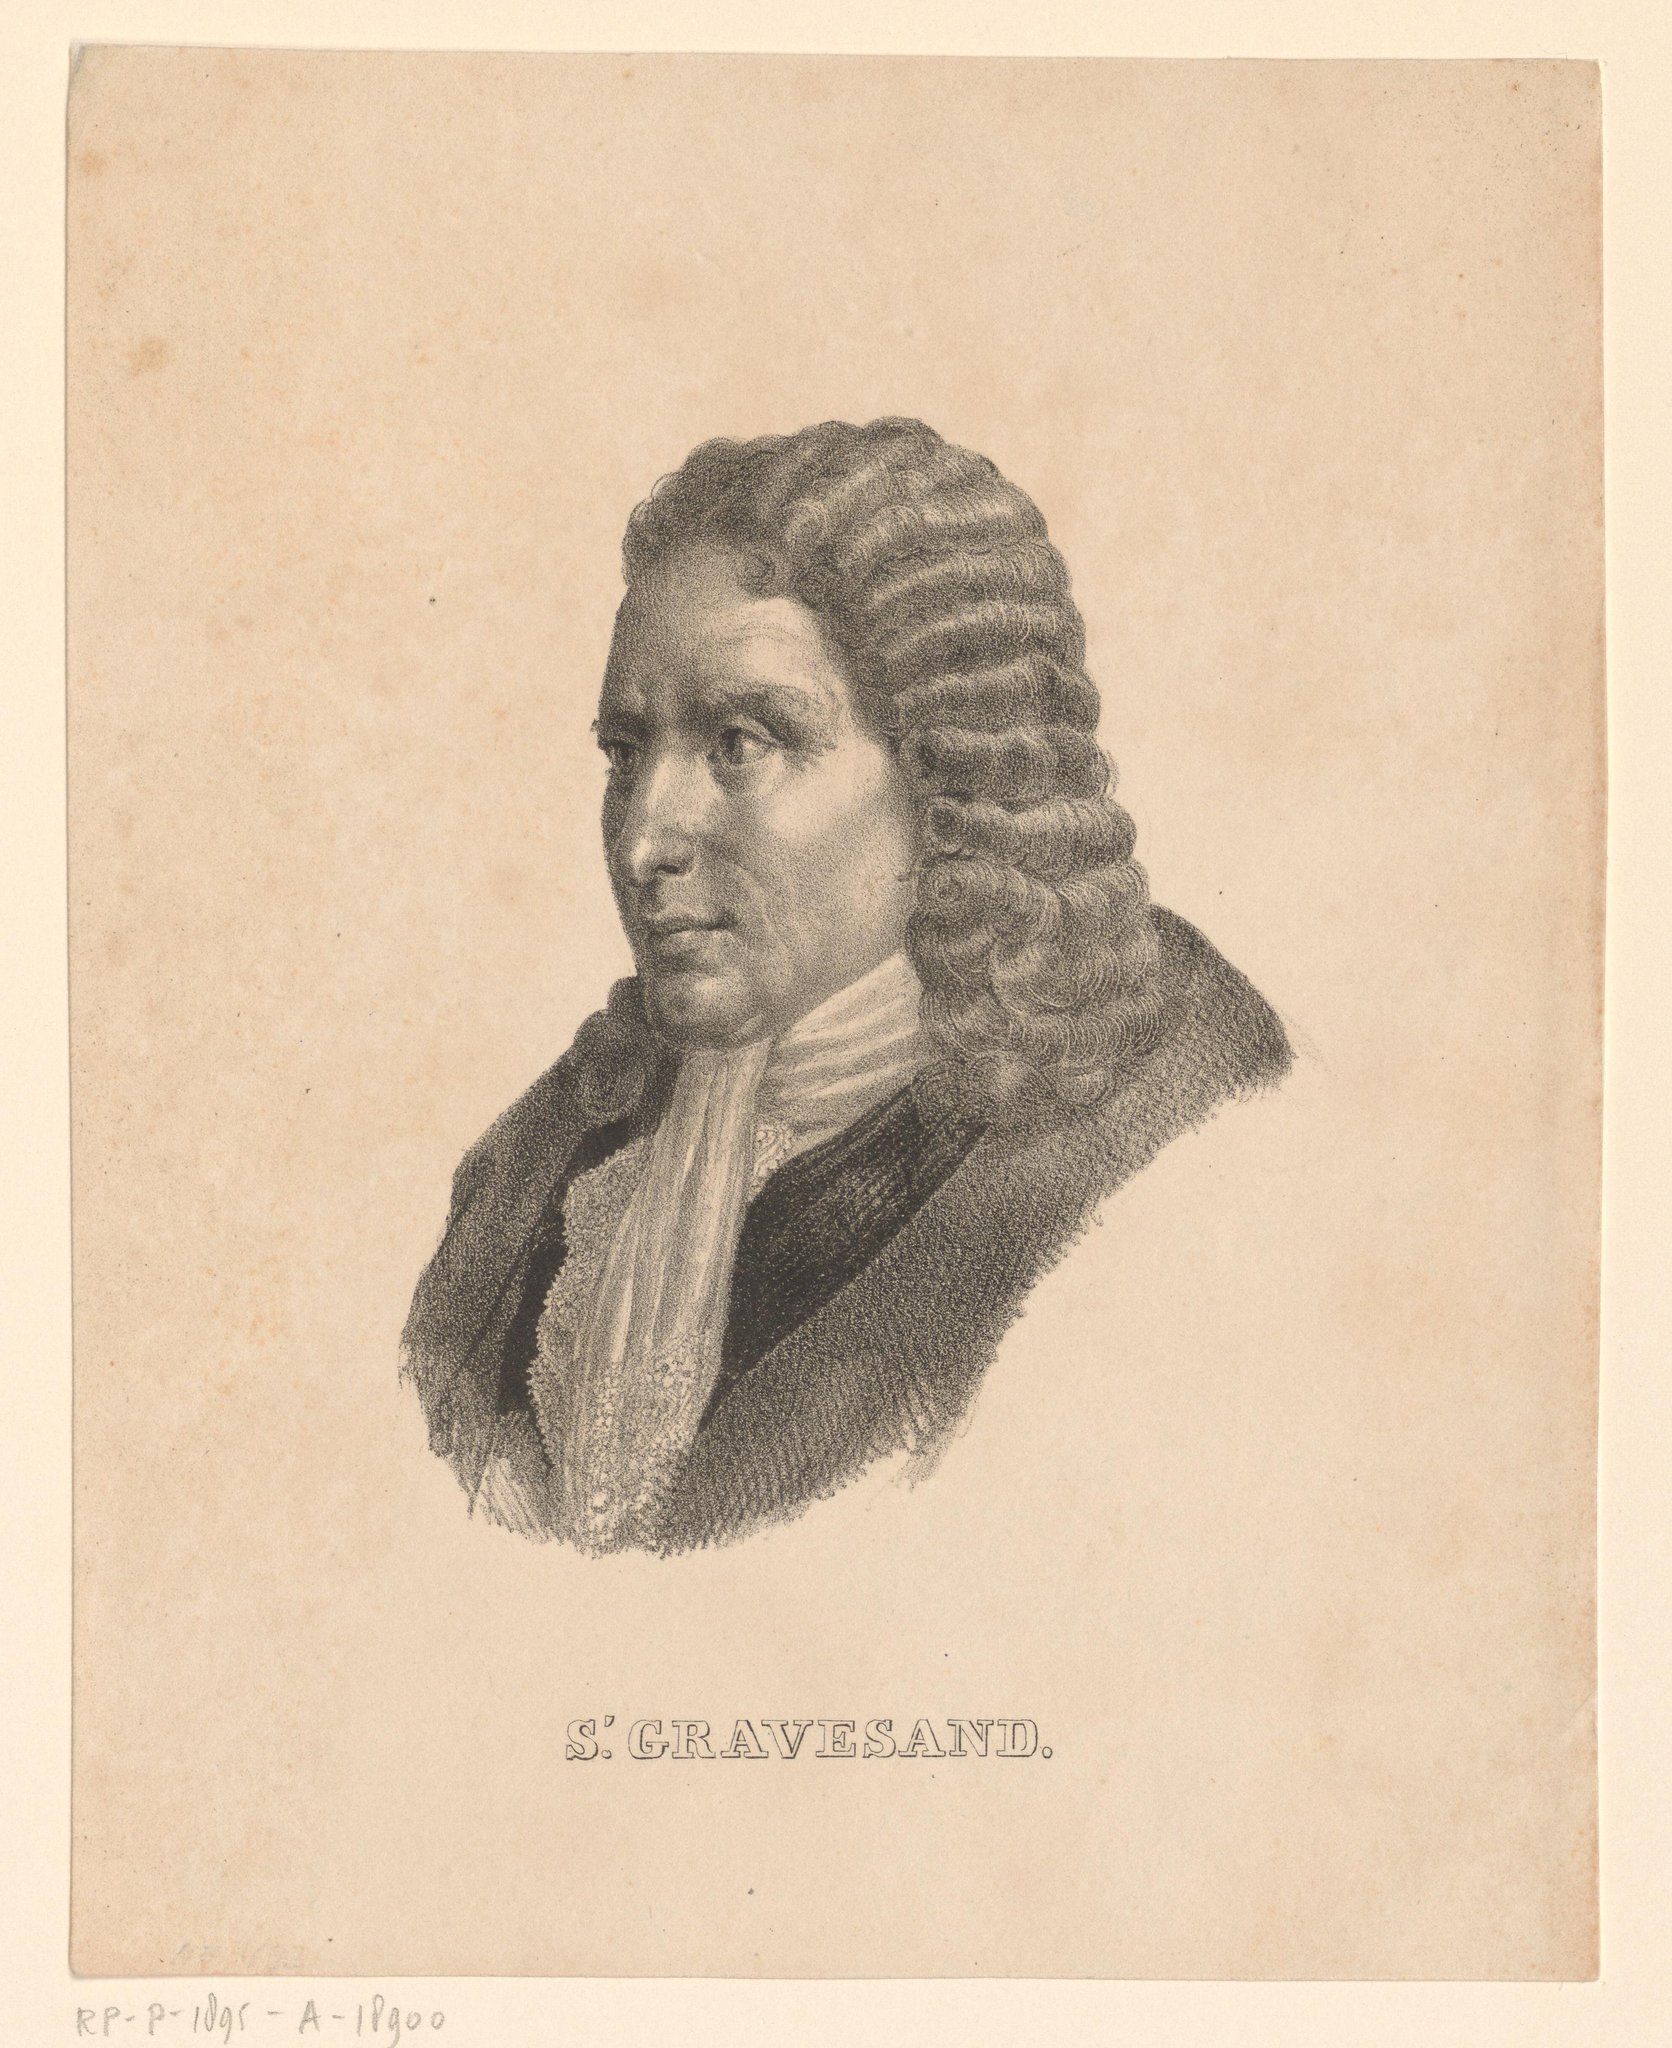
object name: print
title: Portret van Cornelius 's-Gravesande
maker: Anonymous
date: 1700-1800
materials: paper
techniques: lithograph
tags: historical persons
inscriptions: stamp: ‘foto’, collector's mark: Lugt 2228